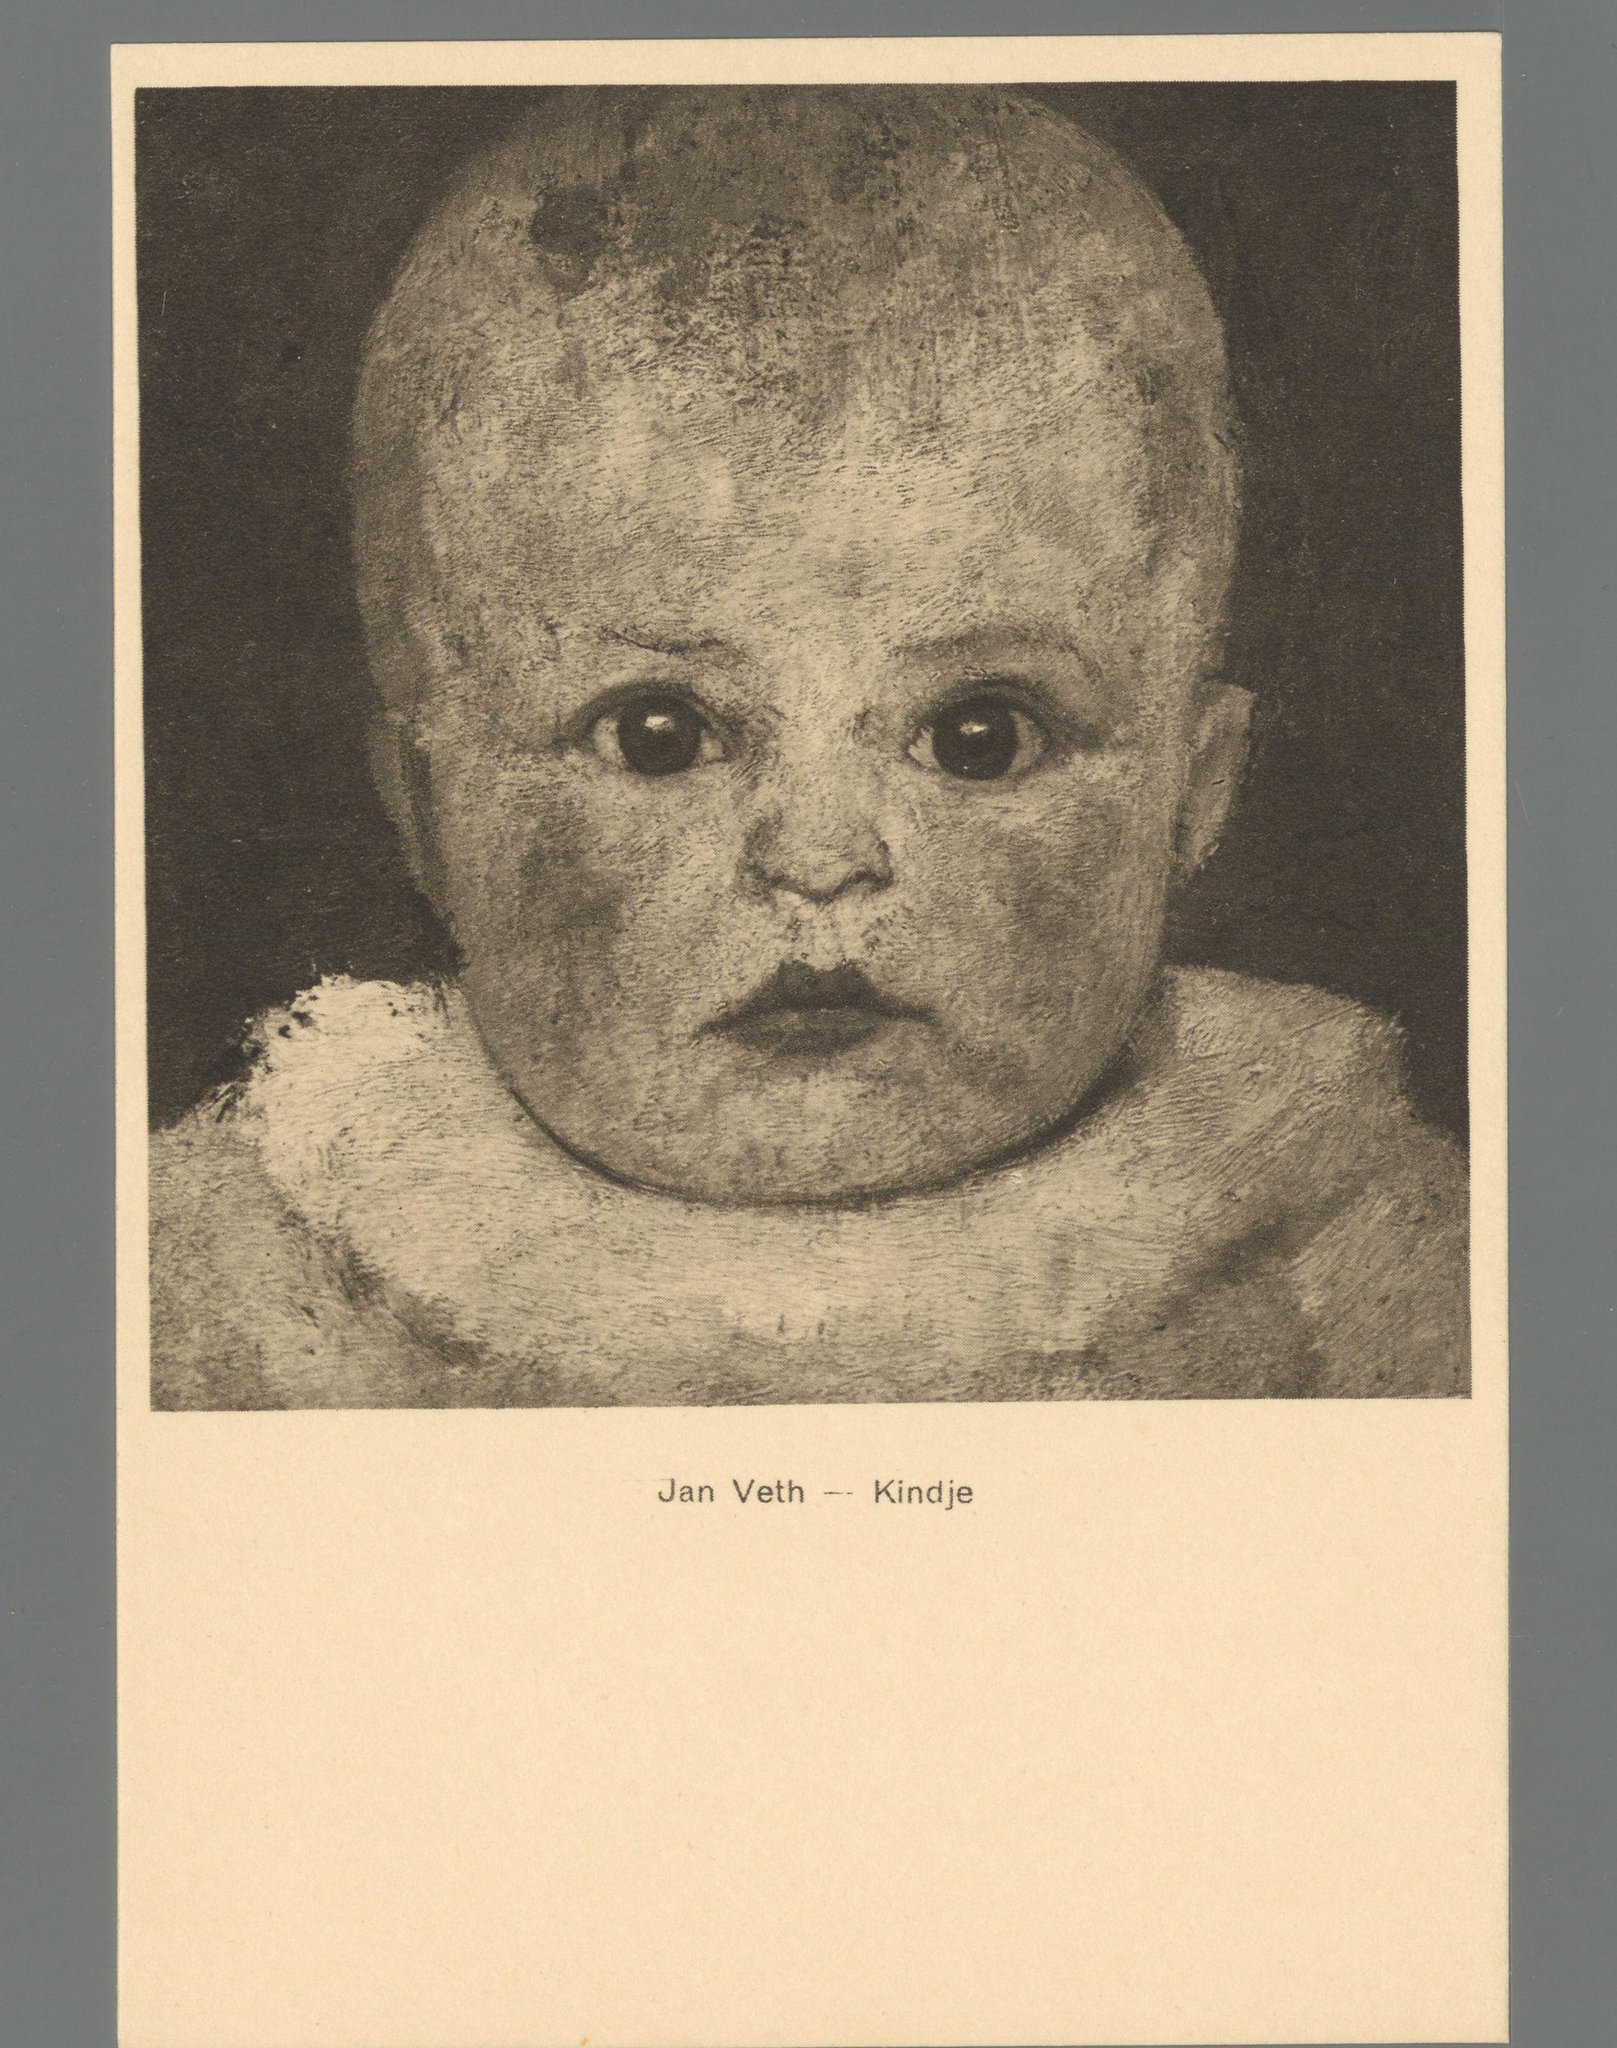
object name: reproduction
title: Jan Veth - Kindje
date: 1928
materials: cardboard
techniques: rotogravure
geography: leiden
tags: toddler, picture, painting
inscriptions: collector's mark: ‘AFE v S’